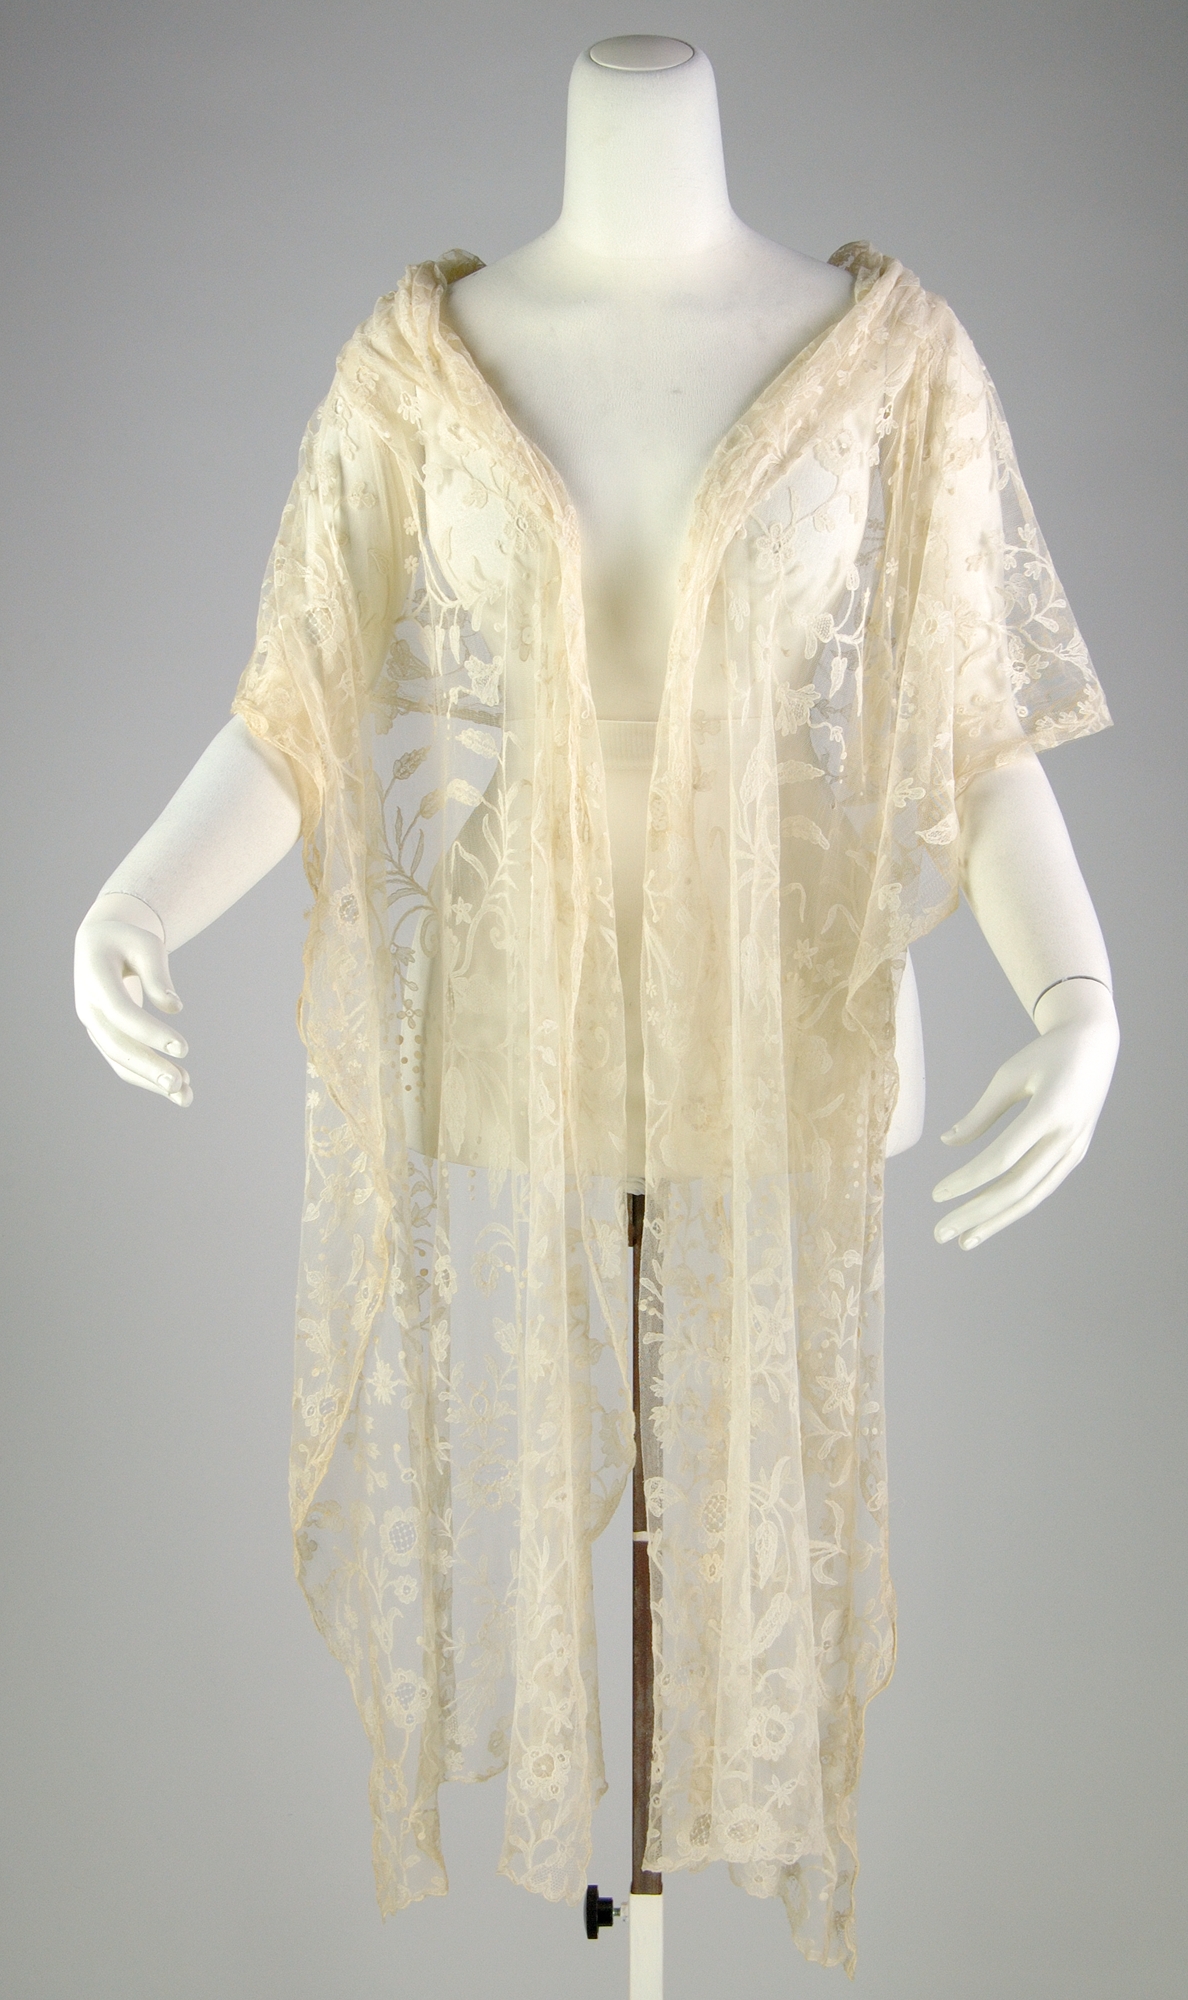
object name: stole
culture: irish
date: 1830-1850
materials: silk